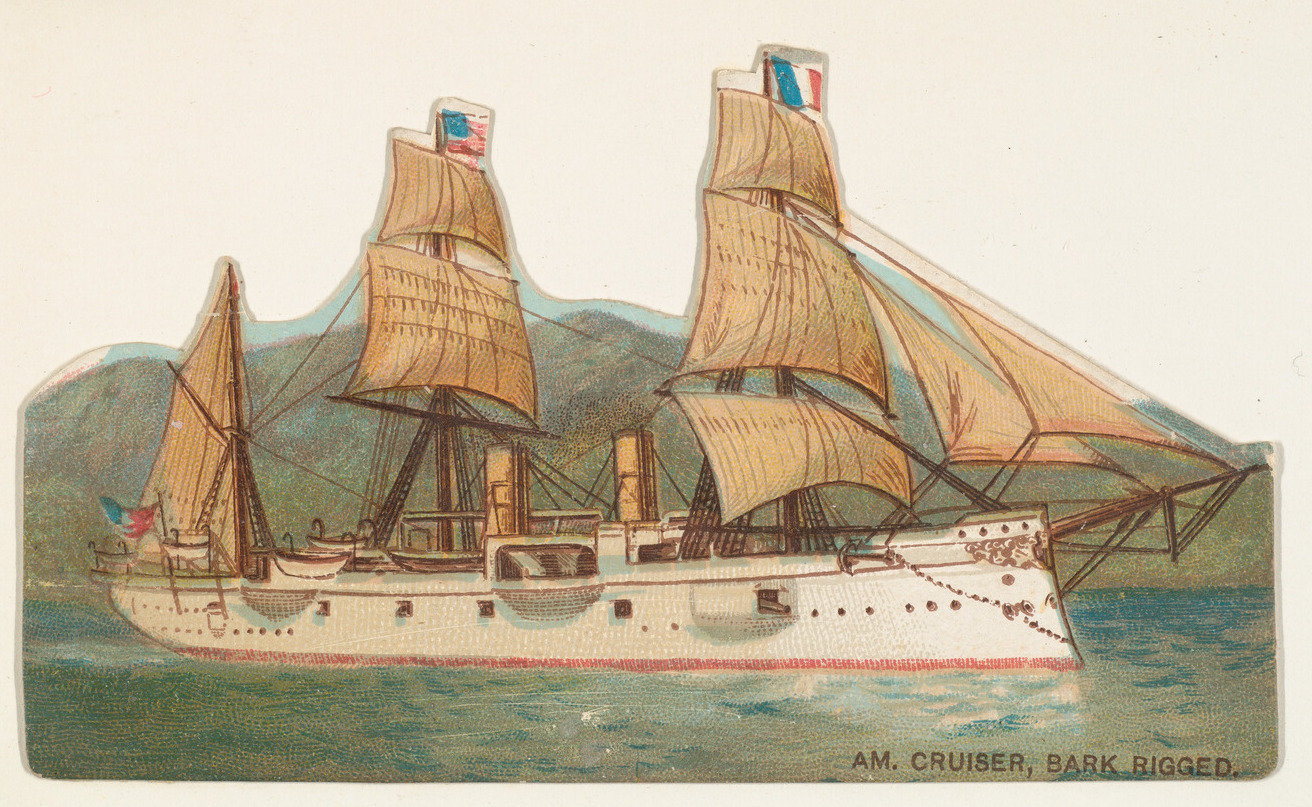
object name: print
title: American Cruiser, Bark Rigged, from the Types of Vessels series (N139) issued by Duke Sons & Co. to promote Honest Long Cut Tobacco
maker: w. duke, sons & co.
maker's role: publisher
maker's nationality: american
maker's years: 1870-1920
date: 1889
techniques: color lithograph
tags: ships